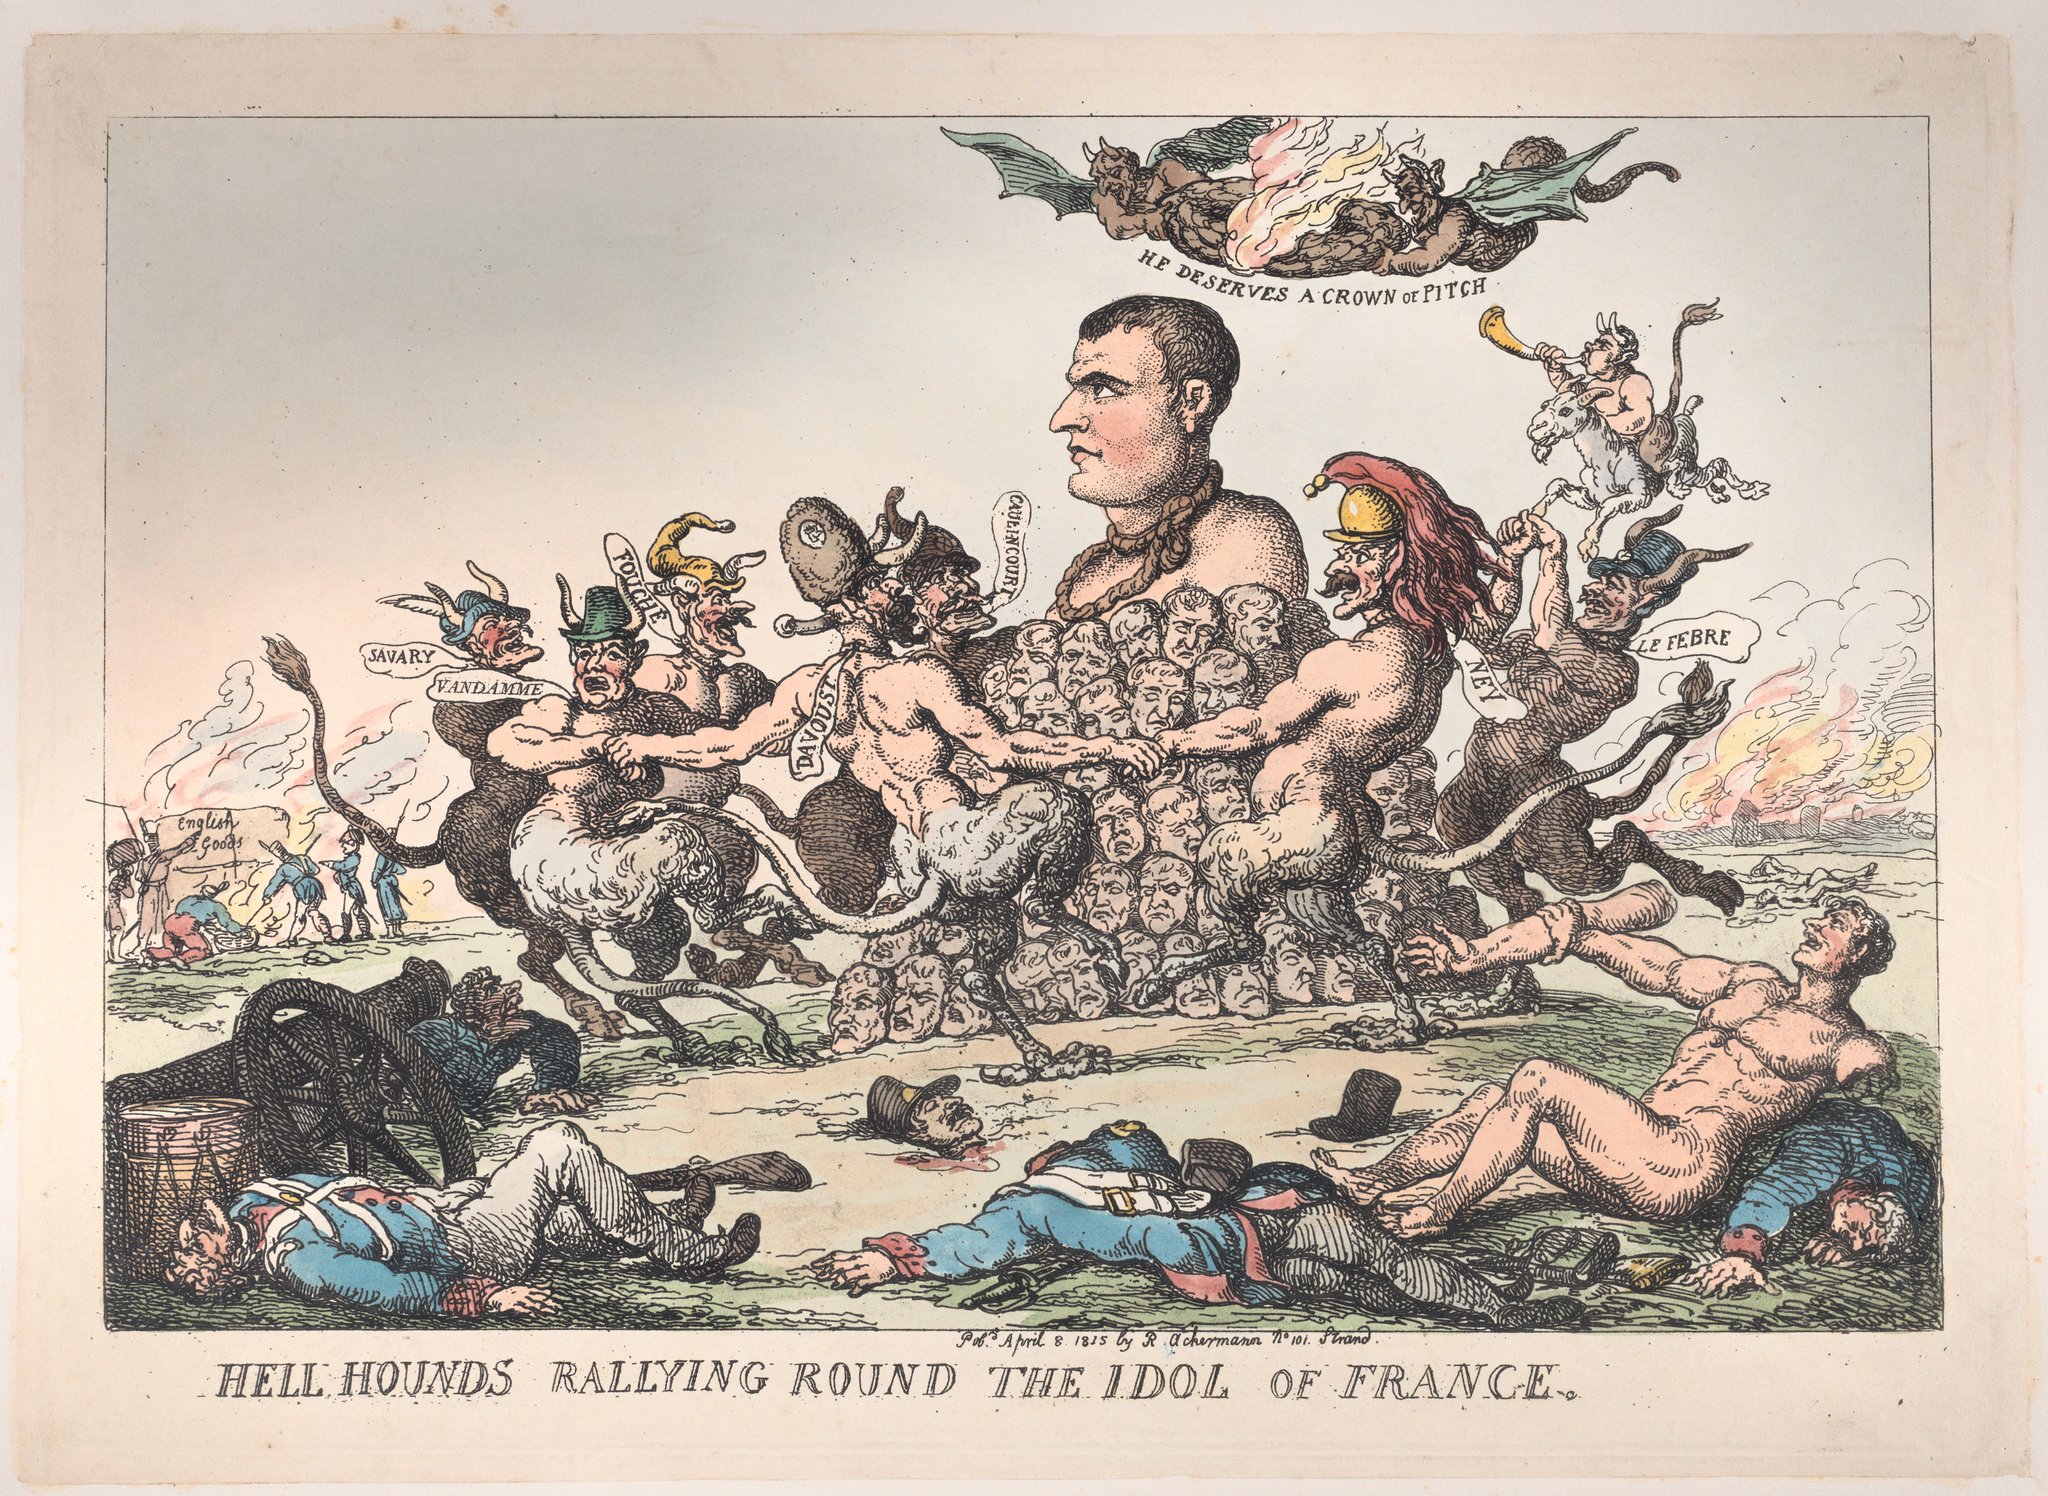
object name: print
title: Hell Hounds Rallying Round the Idol of France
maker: thomas rowlandson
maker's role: artist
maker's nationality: british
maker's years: 1757-1827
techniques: etching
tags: satire,napoleon i,demons,politics